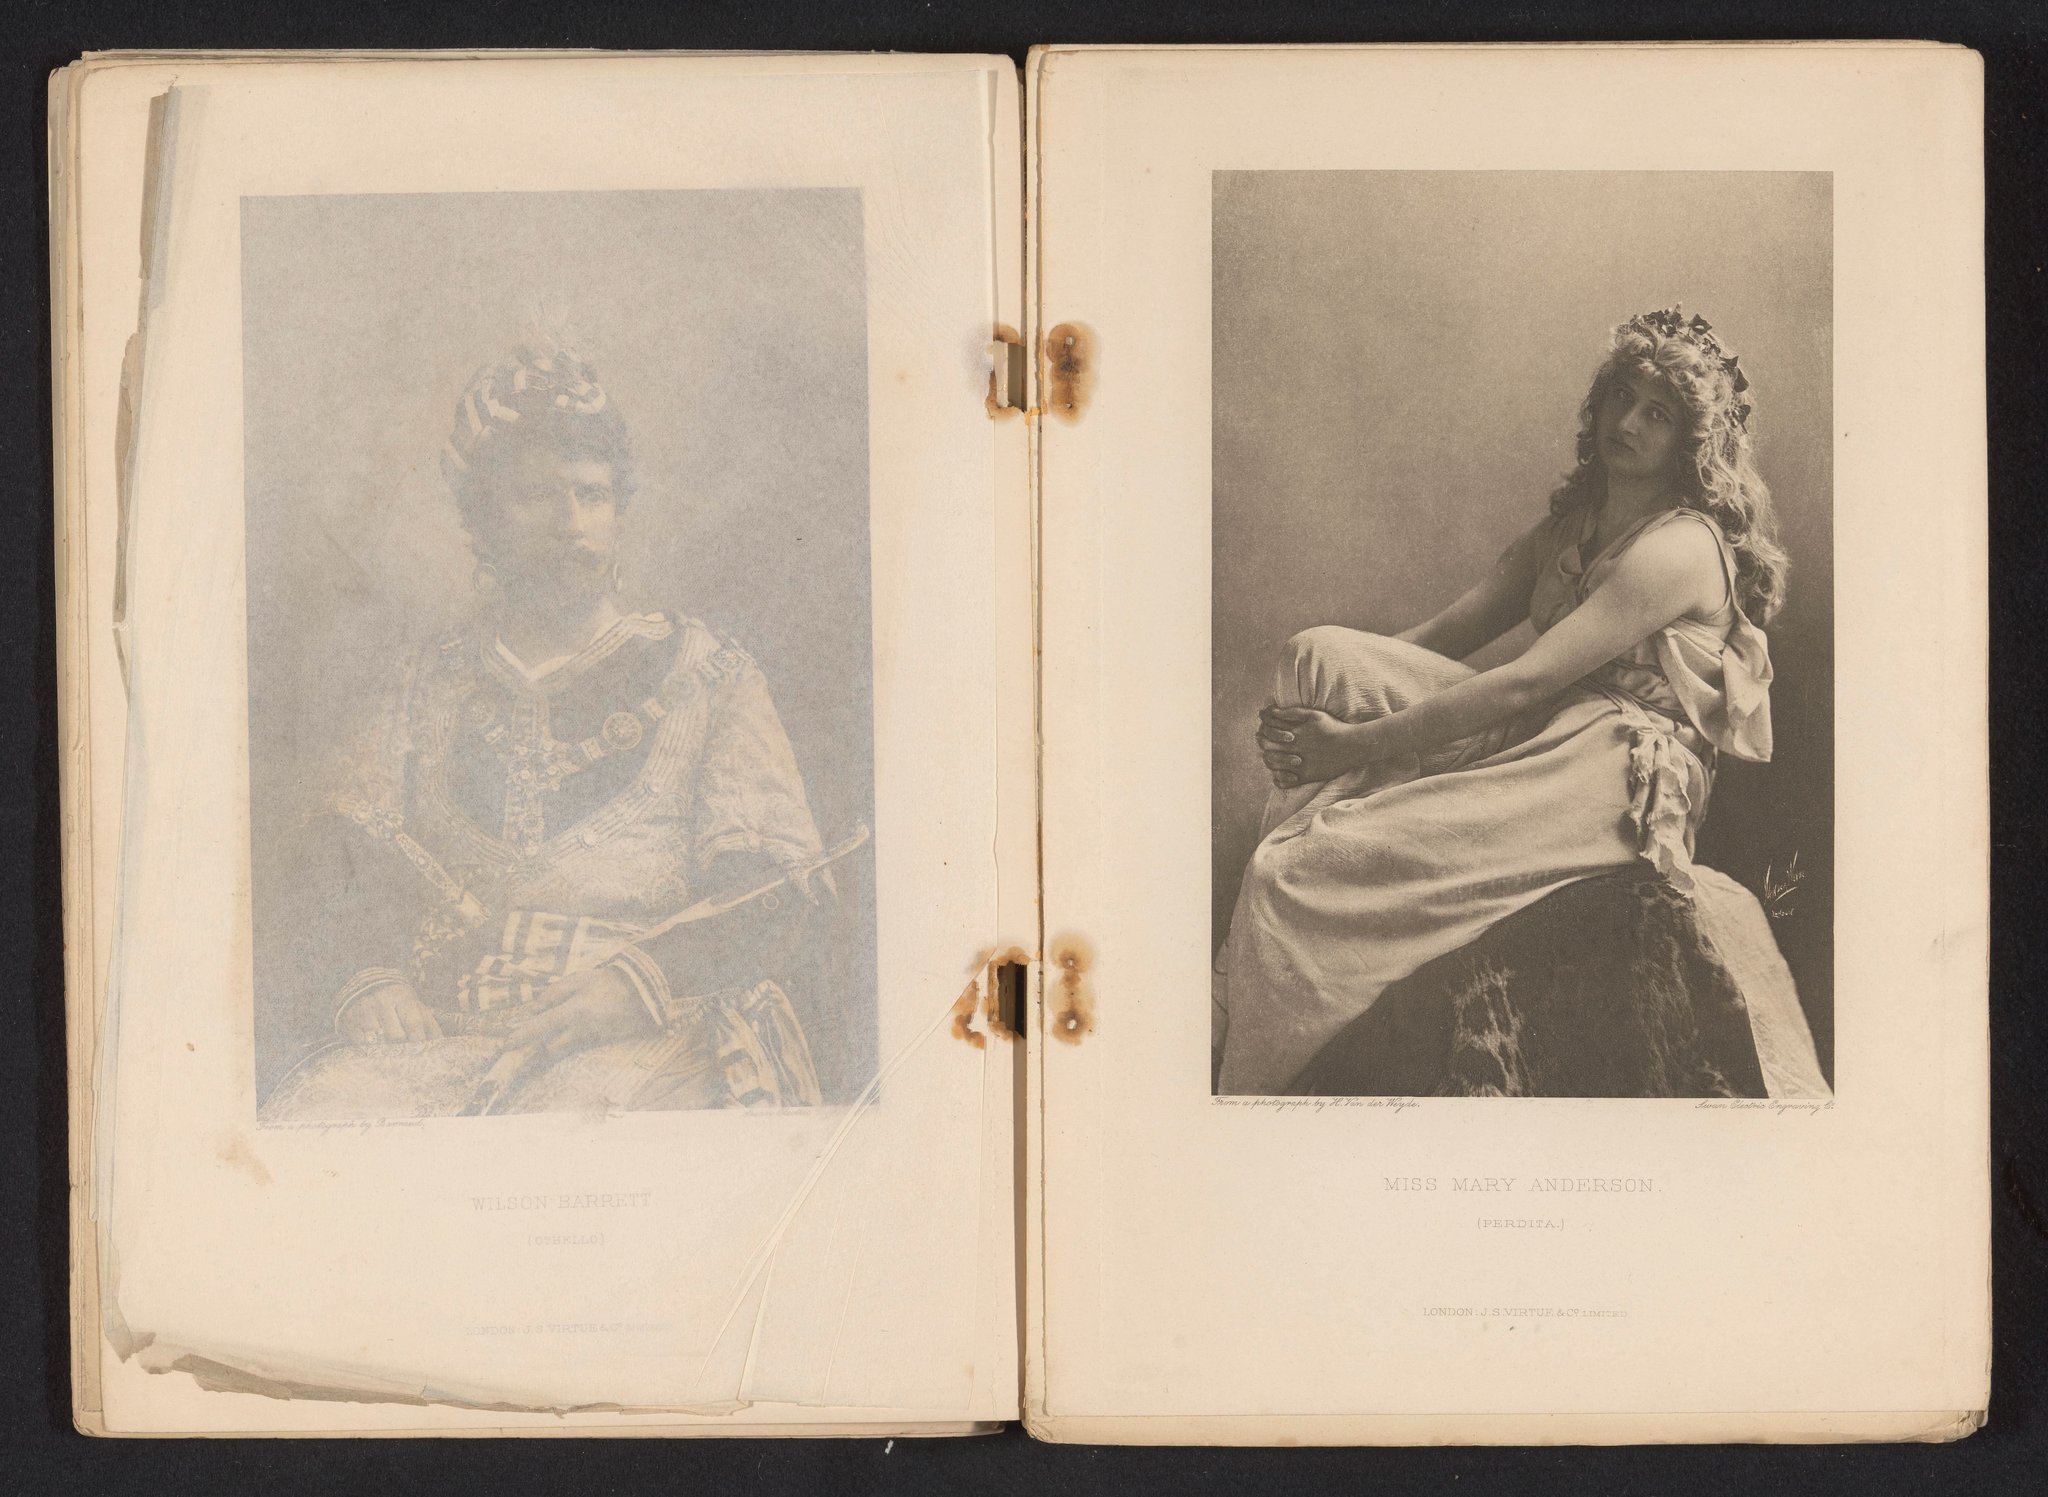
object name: photomechanical print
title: Miss Mary Anderson (Perdita)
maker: henry van der weyde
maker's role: fotograaf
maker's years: 1838-1924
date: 1880-1890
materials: paper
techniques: photoaquatint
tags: portrait of actor, actress